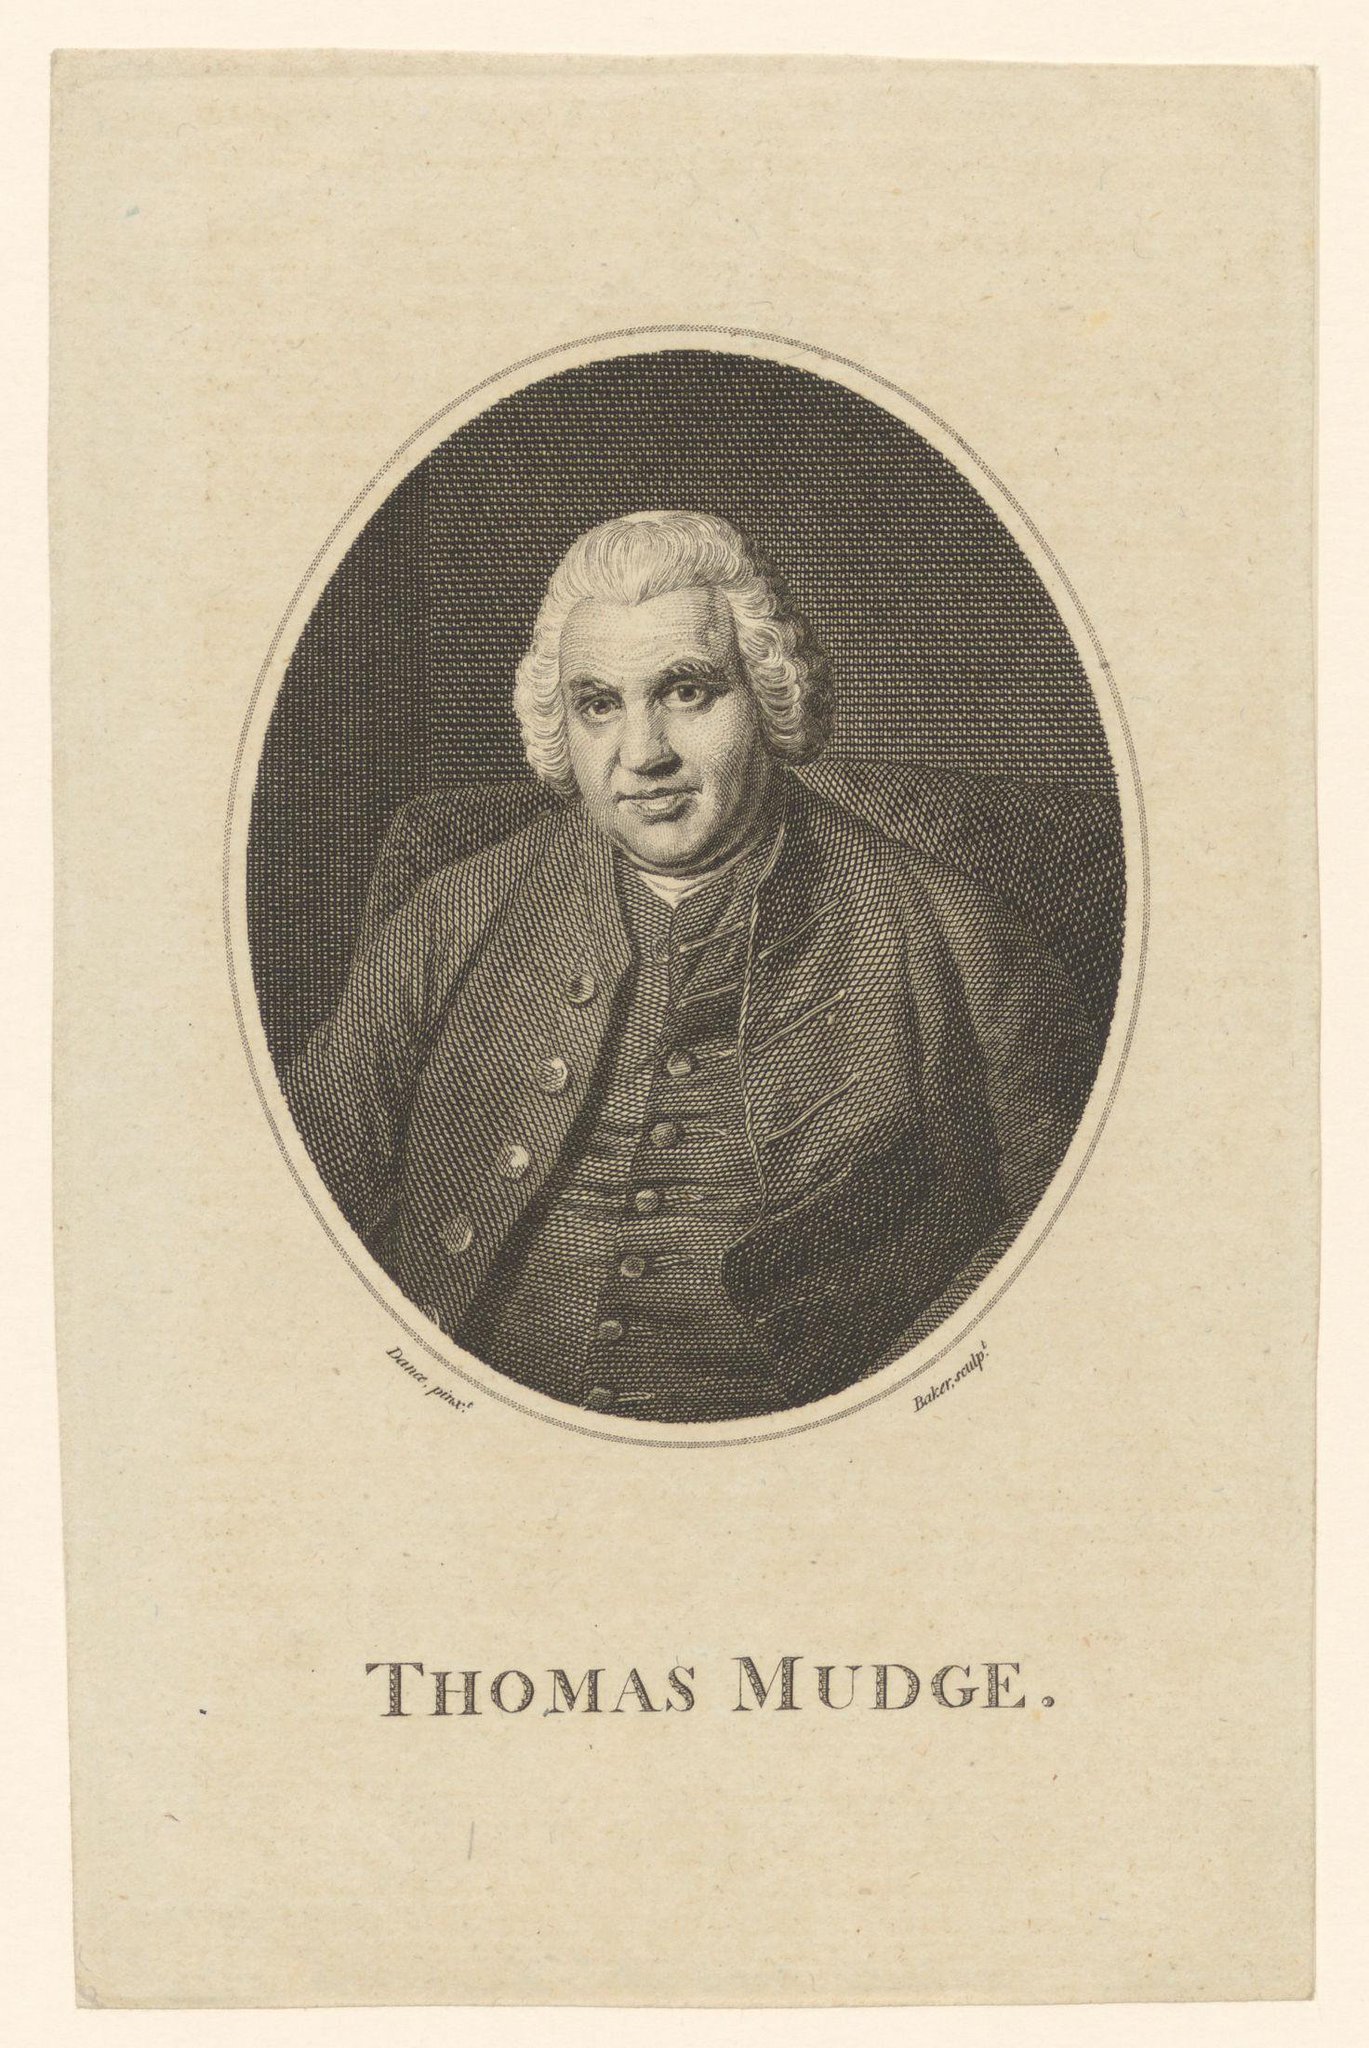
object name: print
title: Thomas Mudge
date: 1772-1776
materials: paper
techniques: engraving, etching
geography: islington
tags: thomas mudge, historical persons, watchmaker, clockmaker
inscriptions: collector's mark: Lugt 2228